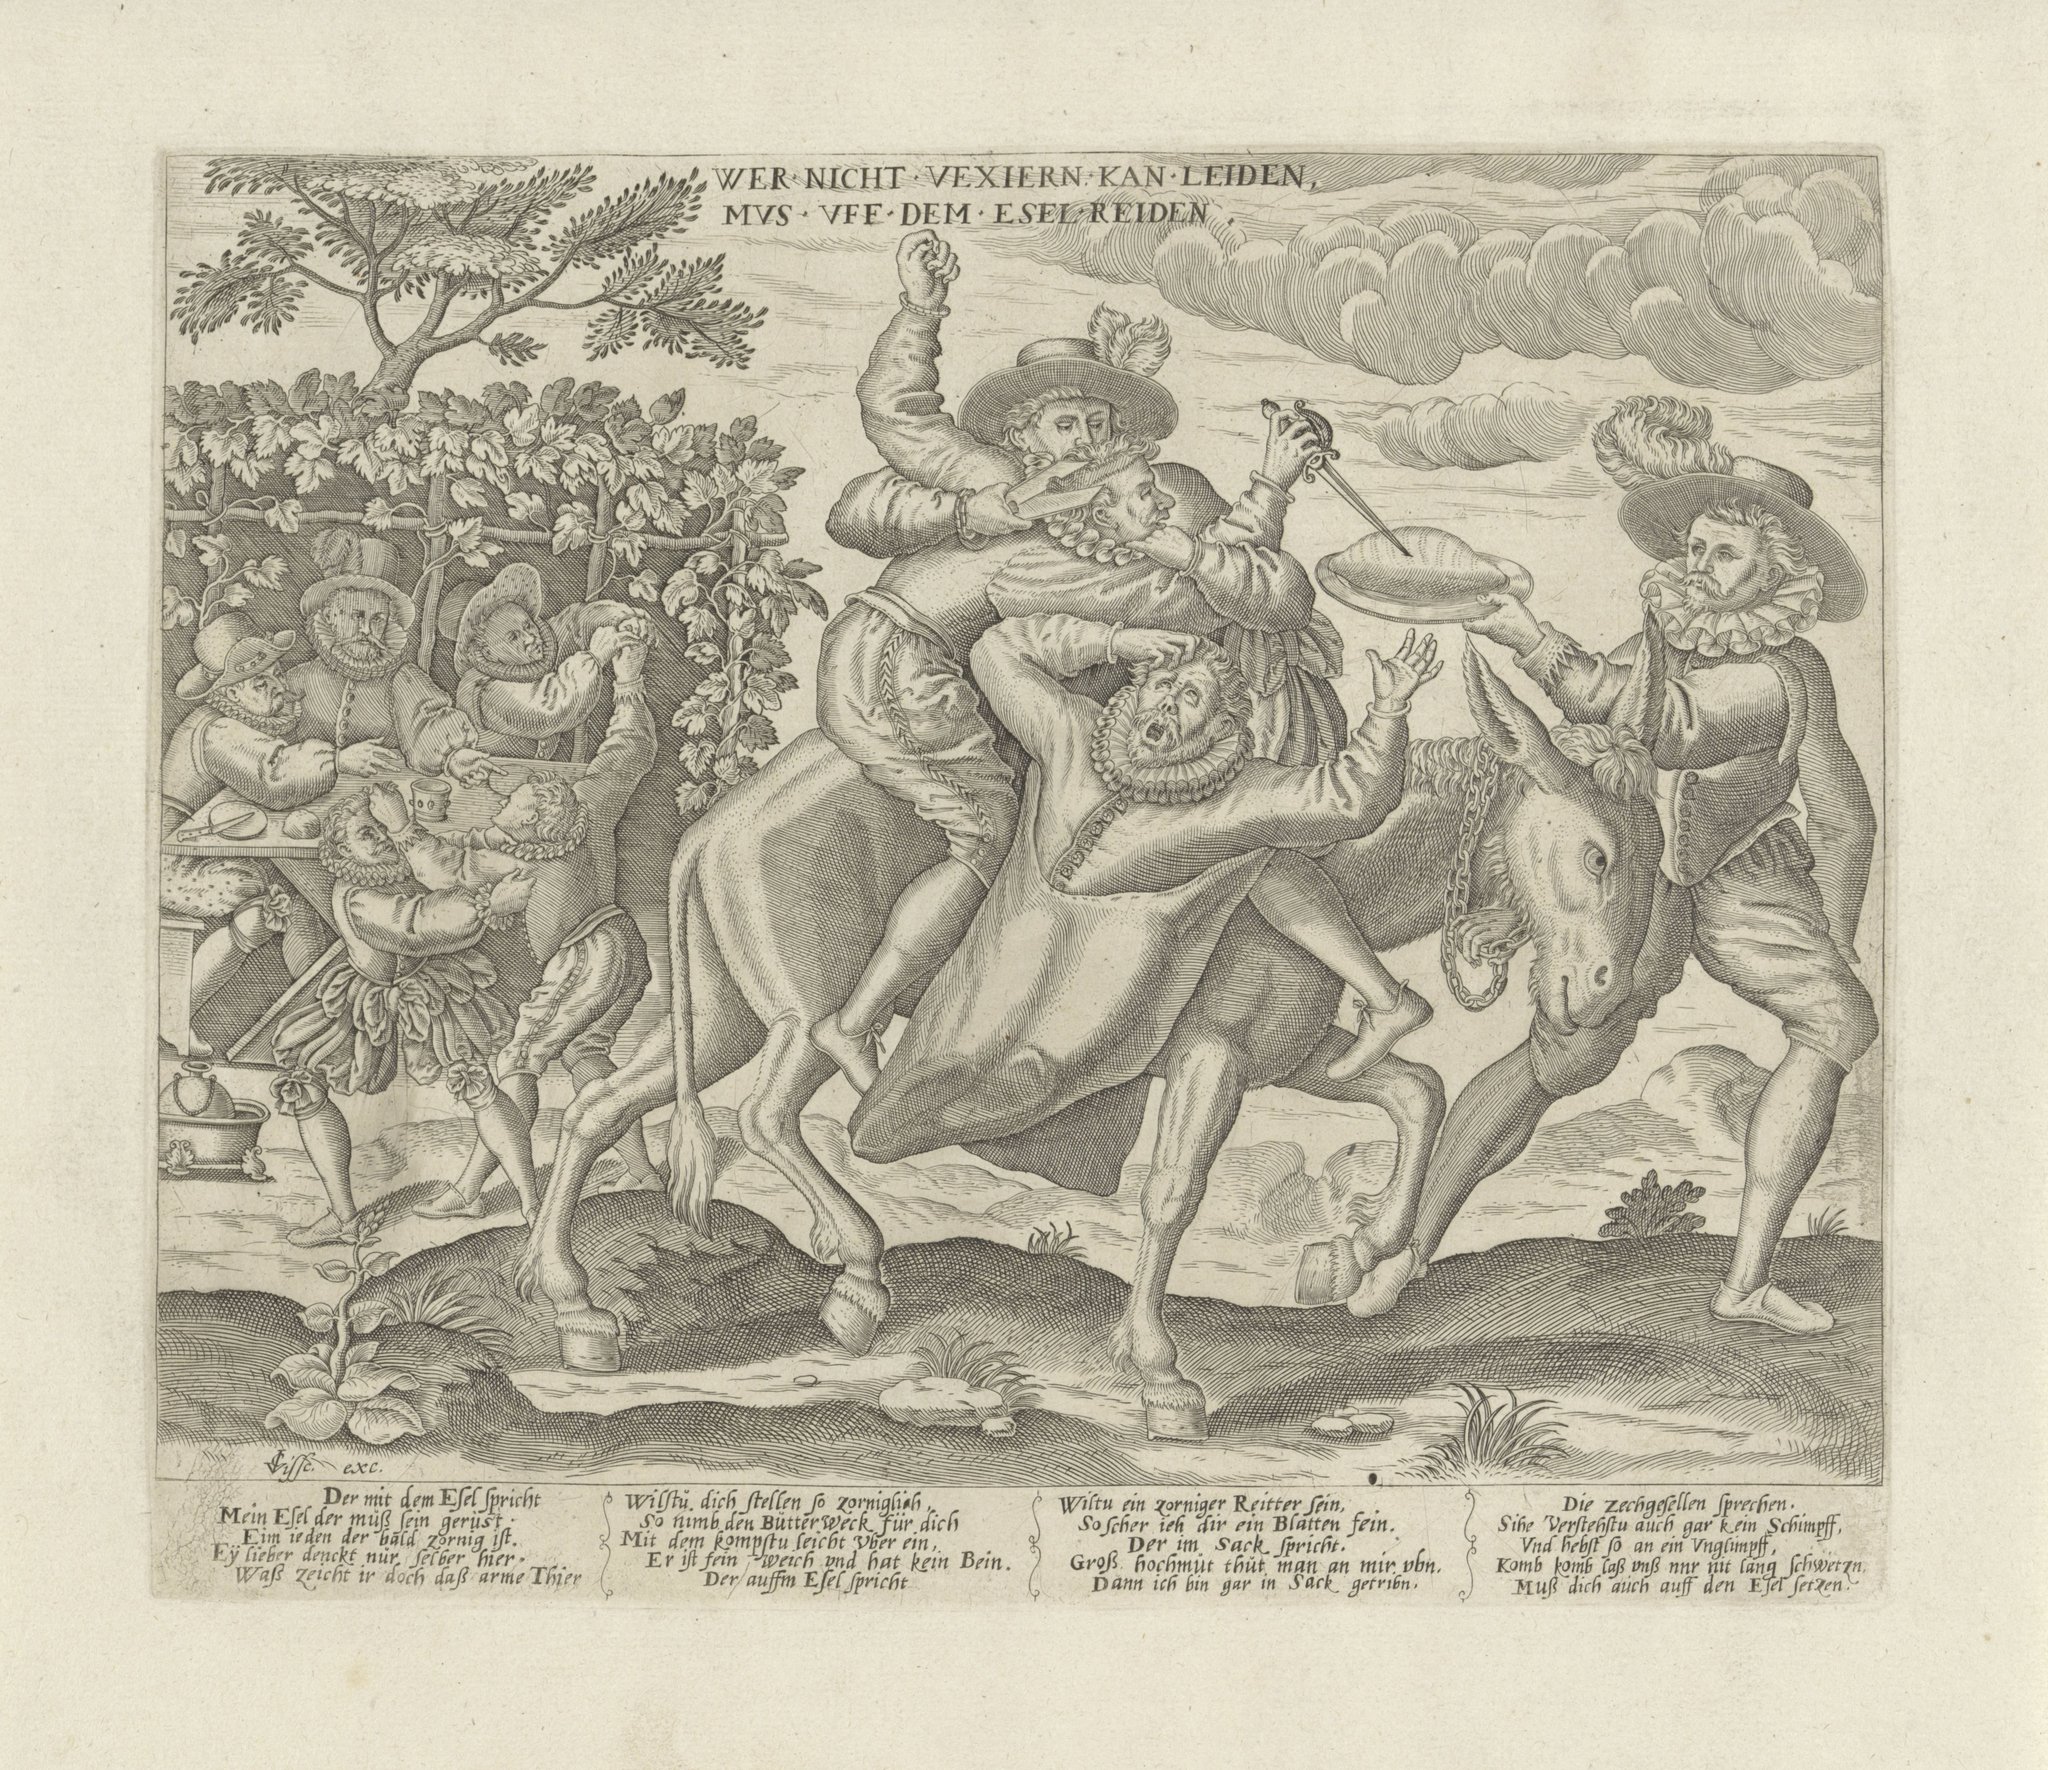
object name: print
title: Wer nicht vexiern kan Leiden mvs vff dem esel reiden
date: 1612-1652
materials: paper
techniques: engraving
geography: amsterdam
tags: ass, donkey, pulling out one's hair, proverbs, sayings, etc., hair-cutting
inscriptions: collector's mark: Lugt 2760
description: Twee mannen worden op een ezel weggevoerd. Een van de mannen prikt met zijn steekwapen in het brood dat hem wordt voorgehouden. Op hetzelfde moment wordt zijn haar geknipt. Een tweede man hangt in een zak aan de ezel, hij schreeuwt en grijpt naar zijn hoofd. Links staan de dezelfde twee mannen te stoeien voor een tafel waar drie mannen achter zitten die hen lijken te beschuldigen. Onder de afbeelding 4 x 5-regelig vers in het Duits. De prent is waarschijnlijk een verbeelding van een 17de eeuws Duits spreekwoord. (heruitgave Duits pamflet 1600)